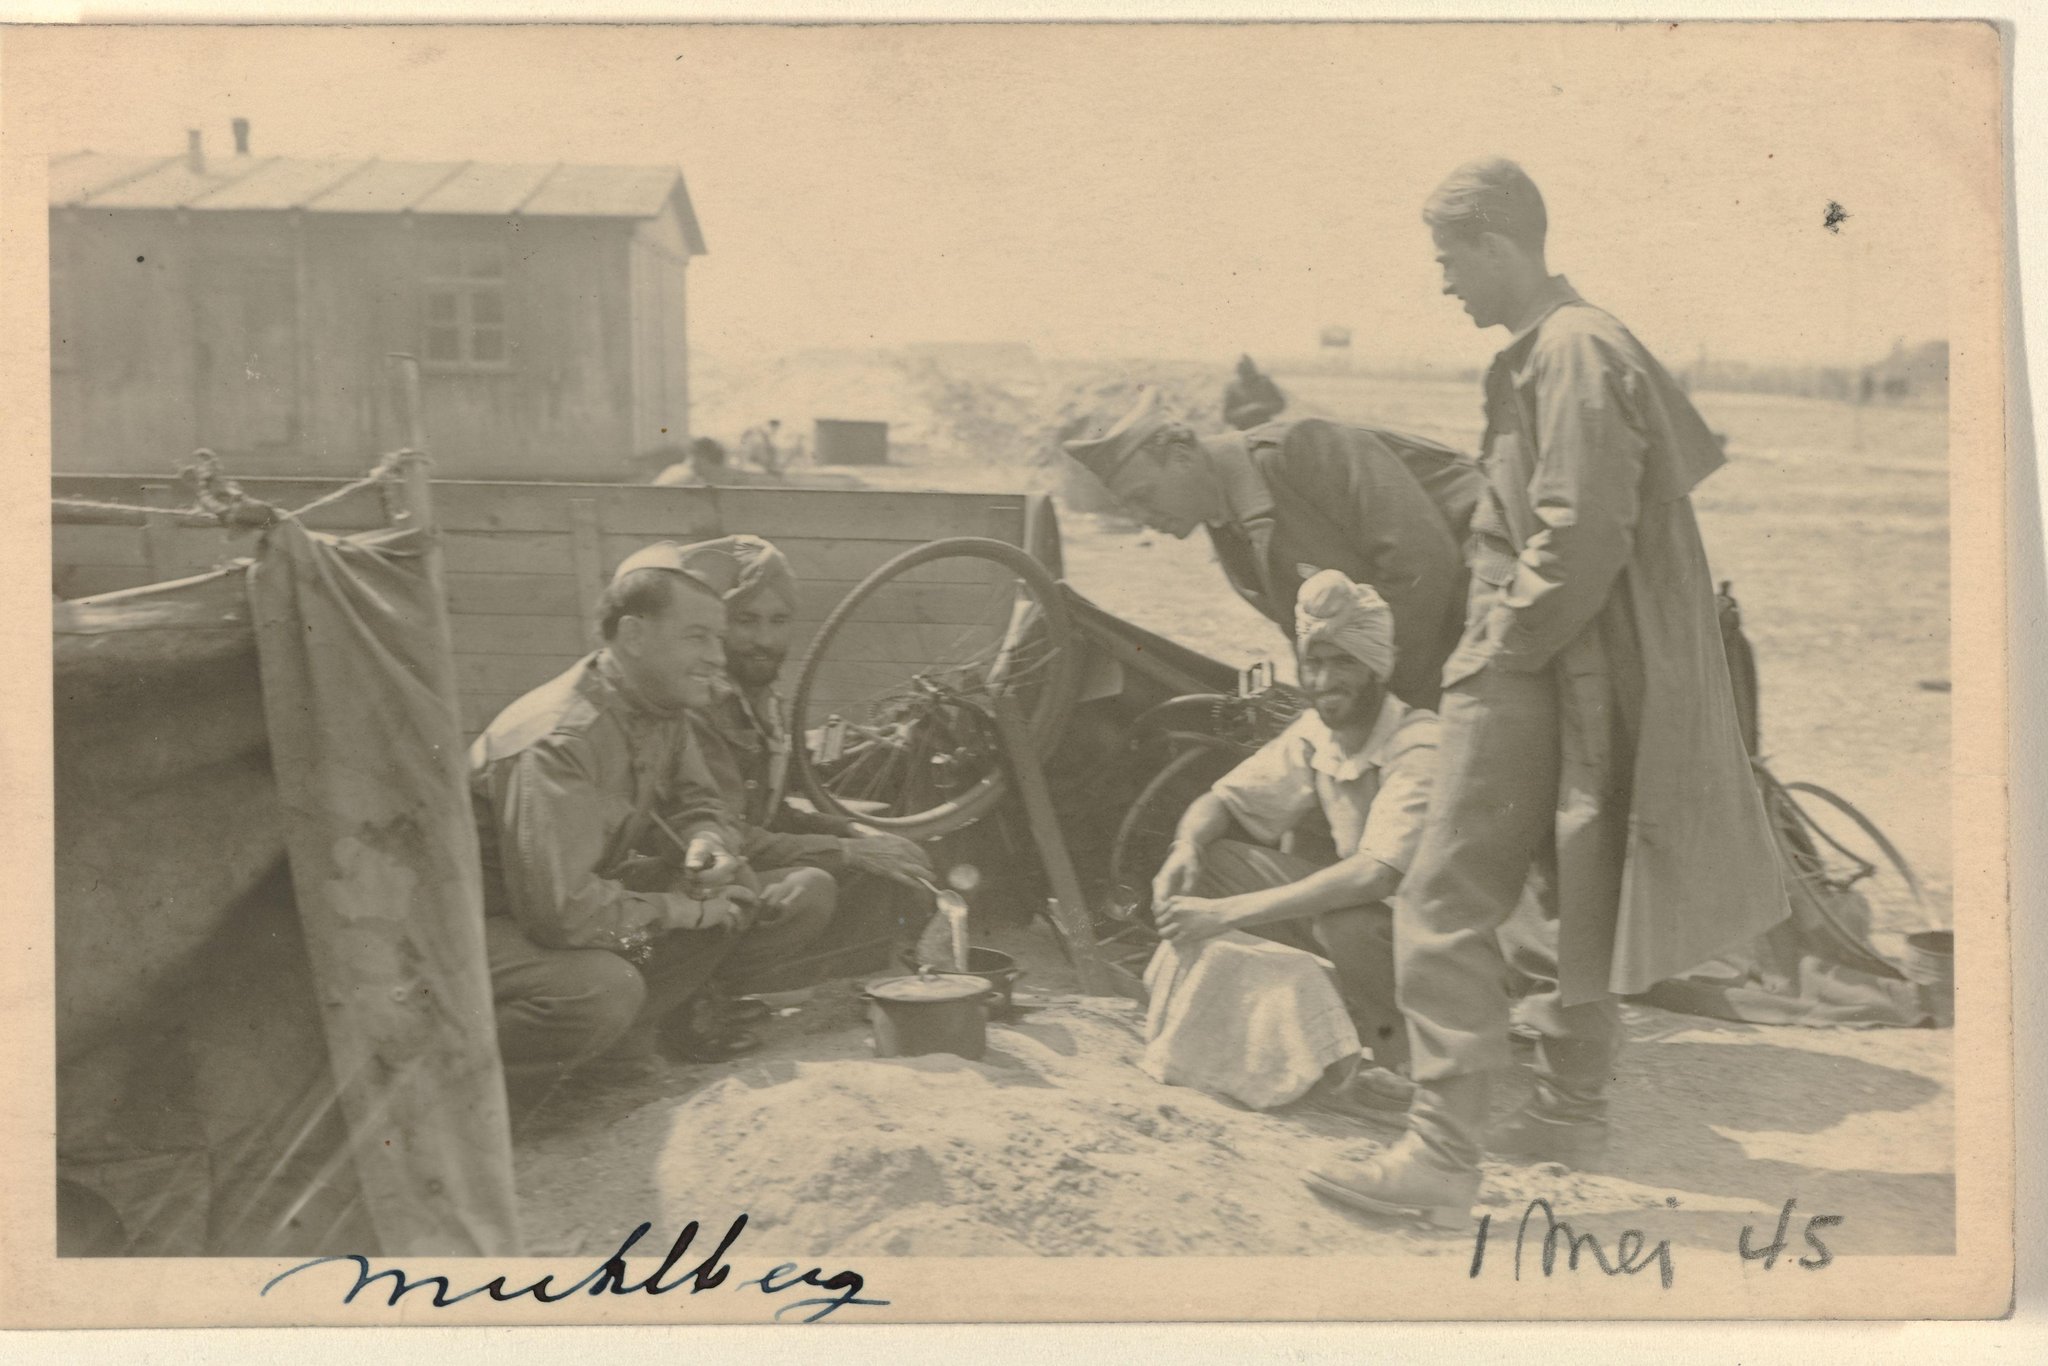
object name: photograph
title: Twee Sikhs en drie andere krijgsgevangenen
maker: dick w.b. van maarseveen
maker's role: fotograaf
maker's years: 1905-1990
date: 1945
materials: photographic support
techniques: gelatin silver print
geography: muhlberg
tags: dick w.b. van maarseveen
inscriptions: inscription: ‘muhlberg 1 mei 45’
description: Twee Sikhs en drie andere krijgsgevangenen bereiden een maaltijd, na de bevrijding op 1 mei 1945. Op de grond onderdelen van een fietsen. Onderdeel van een groep foto's gemaakt door Dick van Maarseveen in het Duitse krijgsgevangenenkamp Stalag IV B in Mühlberg in de periode 1943-1945.